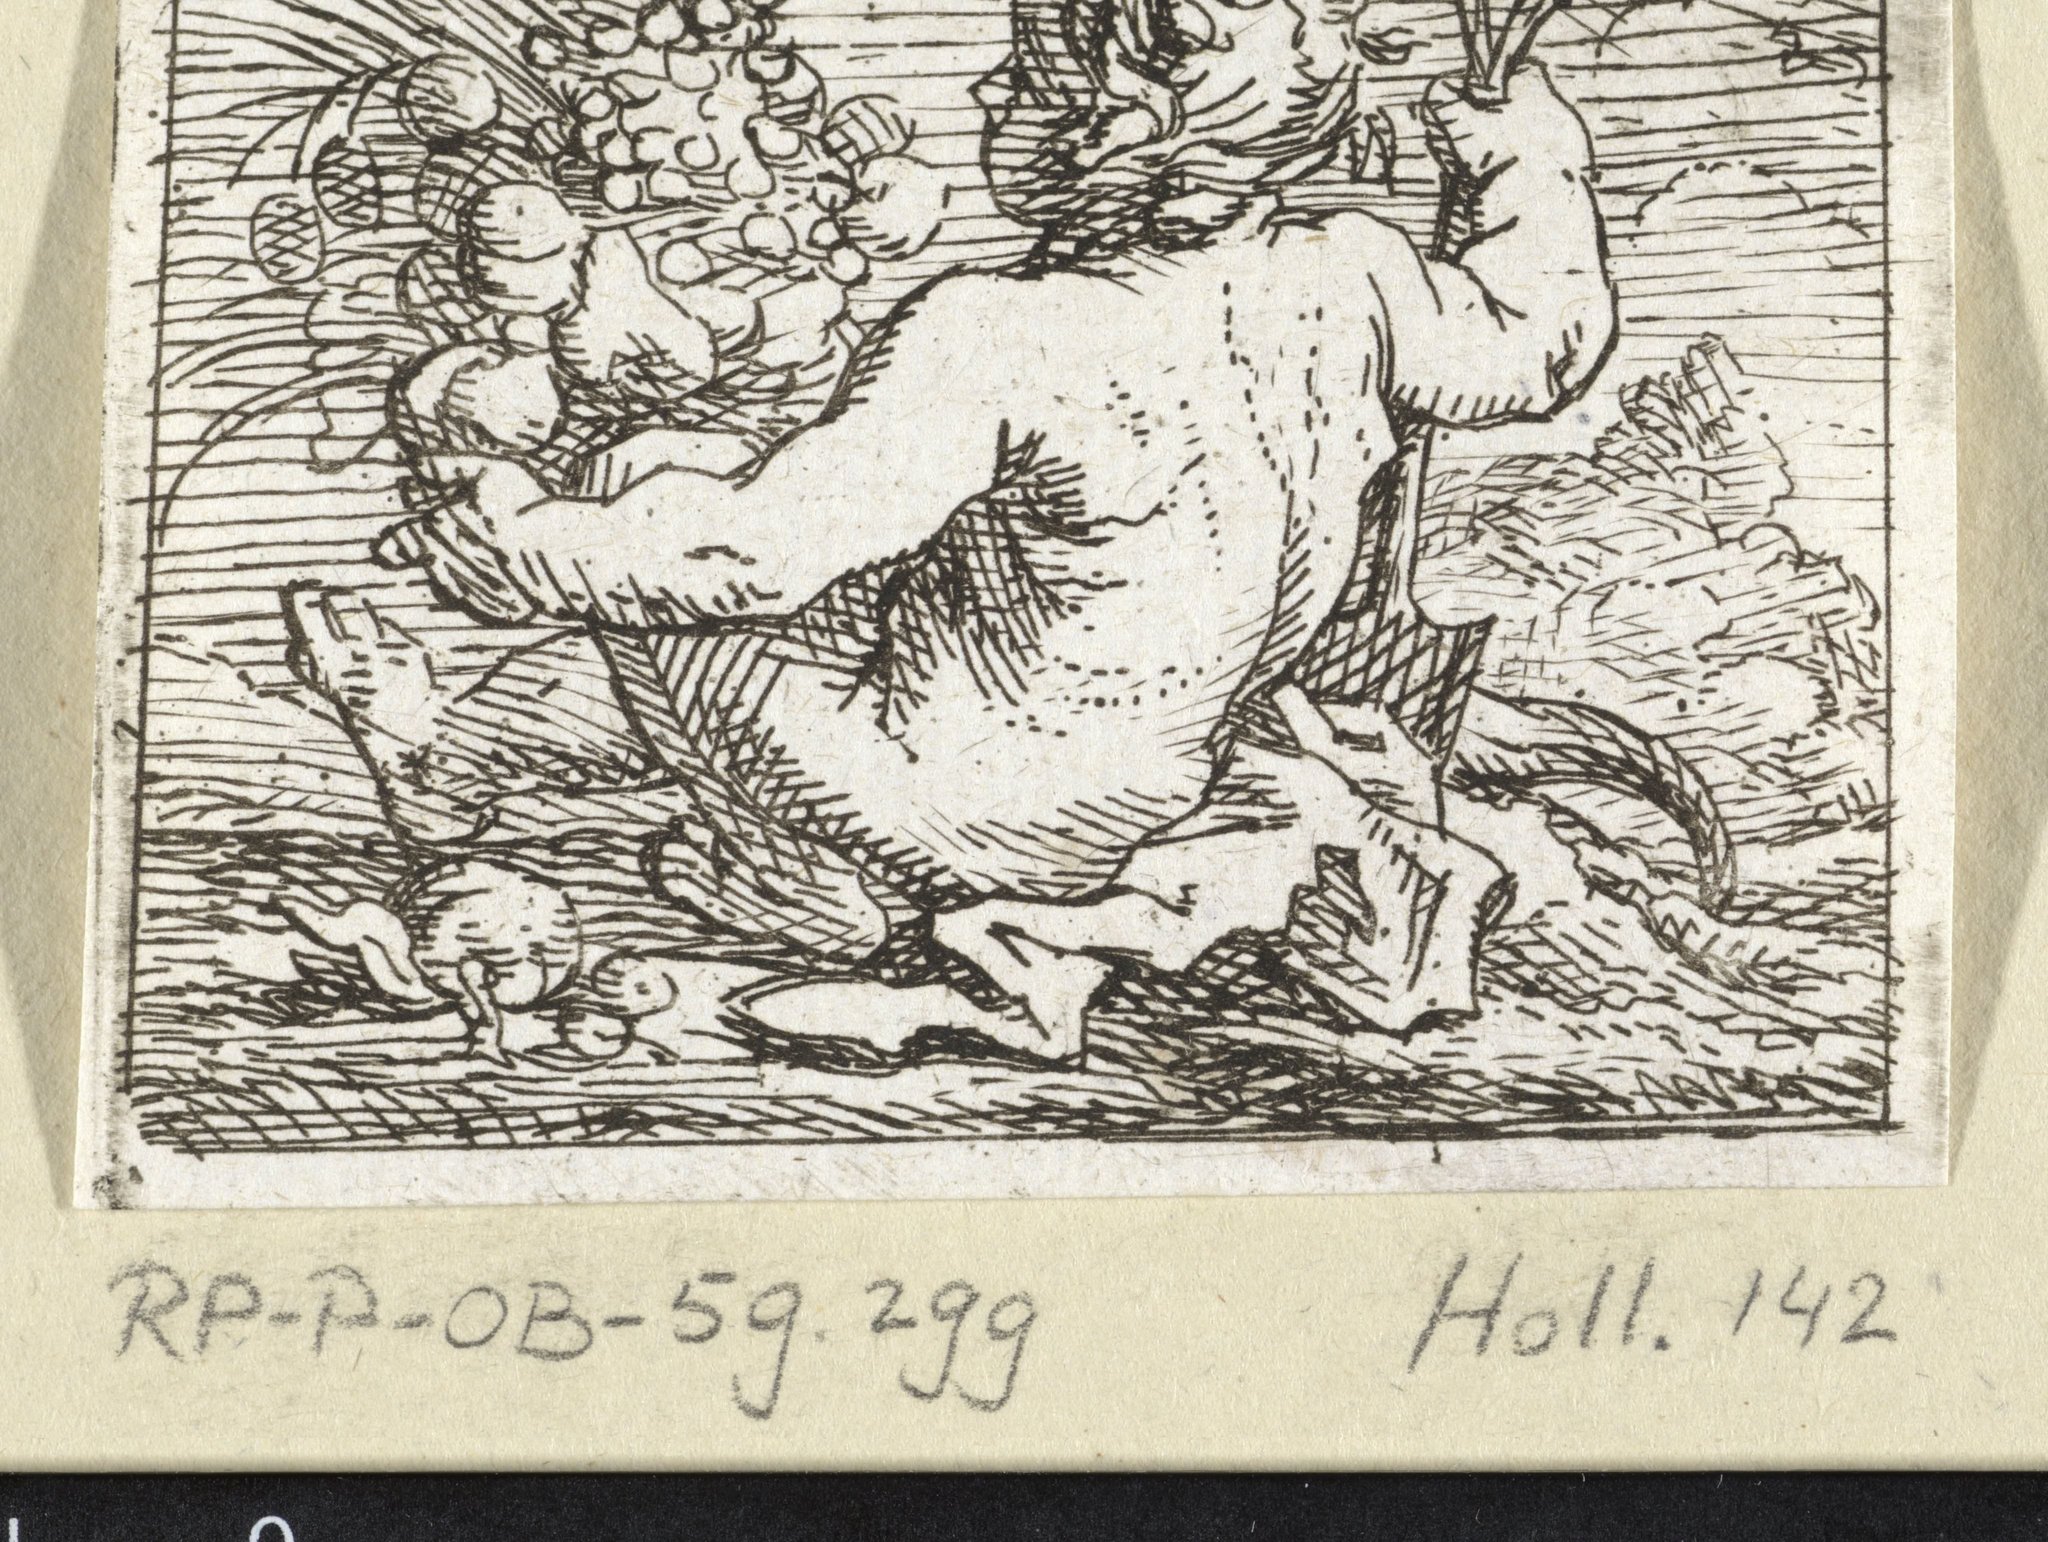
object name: print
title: De vier elementen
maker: cornelis schut (i)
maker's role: draughtsman, print maker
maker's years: 1597-1655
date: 1618-1655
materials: paper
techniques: engraving, etching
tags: earth (one of the four elements)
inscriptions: collector's mark: Lugt 240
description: Een naakt kind zit op de grond. Hij houdt een spade vast. In zijn andere hand heeft hij een hoorn des overvloeds.